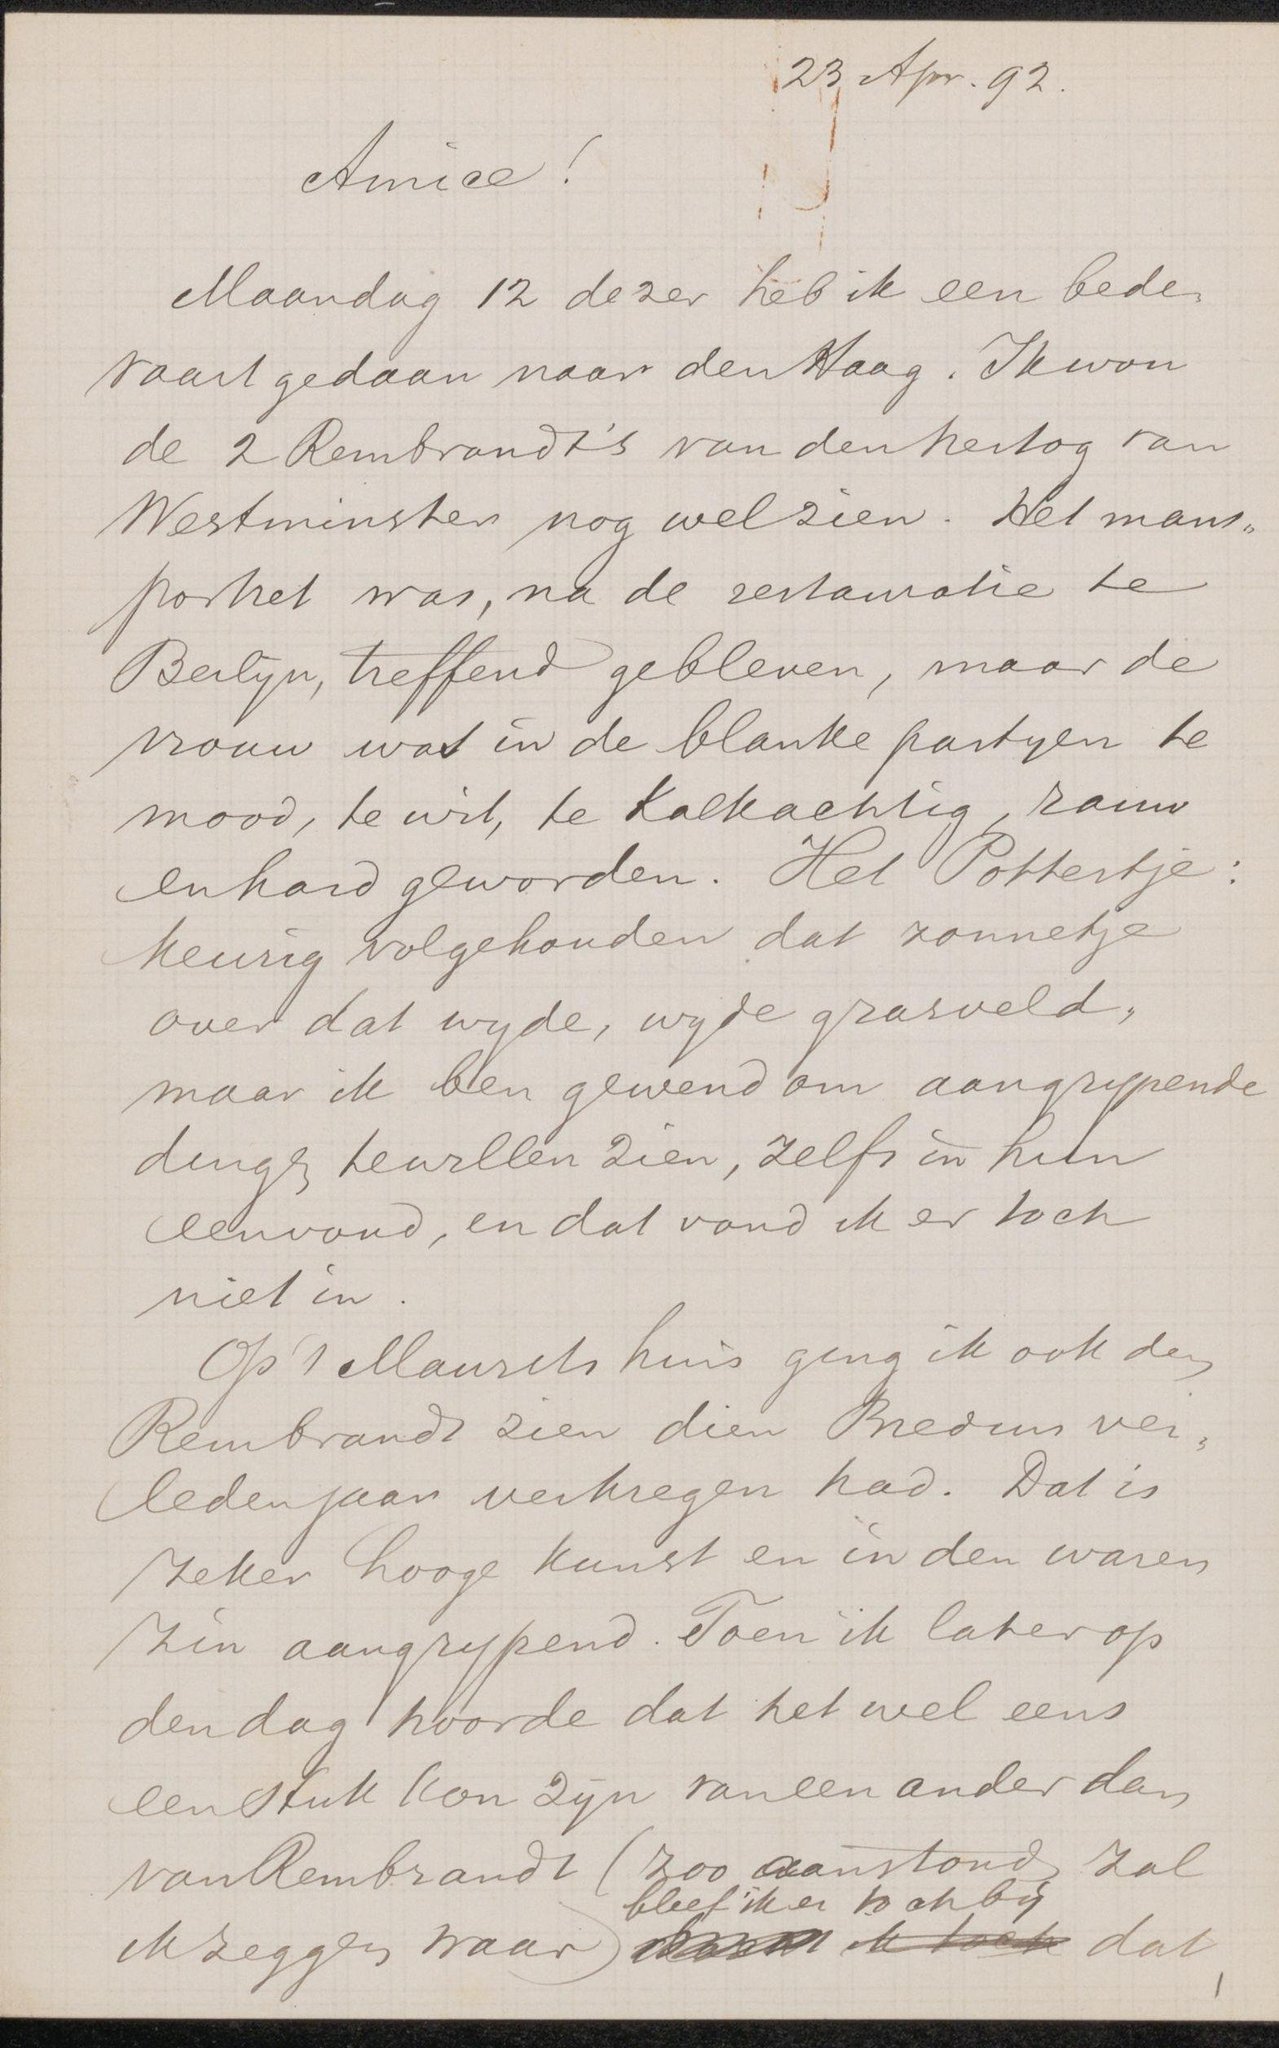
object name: letter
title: Brief aan Jan Veth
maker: martinus cornelis lebret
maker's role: verzamelaar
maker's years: 1833-1894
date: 1892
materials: ink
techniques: pen, writing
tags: jozef israëls, johannes bosboom, rotterdam, george hendrik breitner, dordrecht, print maker, designer, jan veth, the hague, painter, draughtsman, willem maris, jacob maris, leiden, rembrandt van rijn, utrecht, antonie cornelis loffelt, albert verwey, amsterdam, abraham bredius, hermanus gijsbertus tersteeg, photography, cinematography, workshop, studio of the artist (in general), exhibition ~ art, historical persons (portraits and scenes from the life), voorburg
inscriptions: collector's mark: ‘RPK’